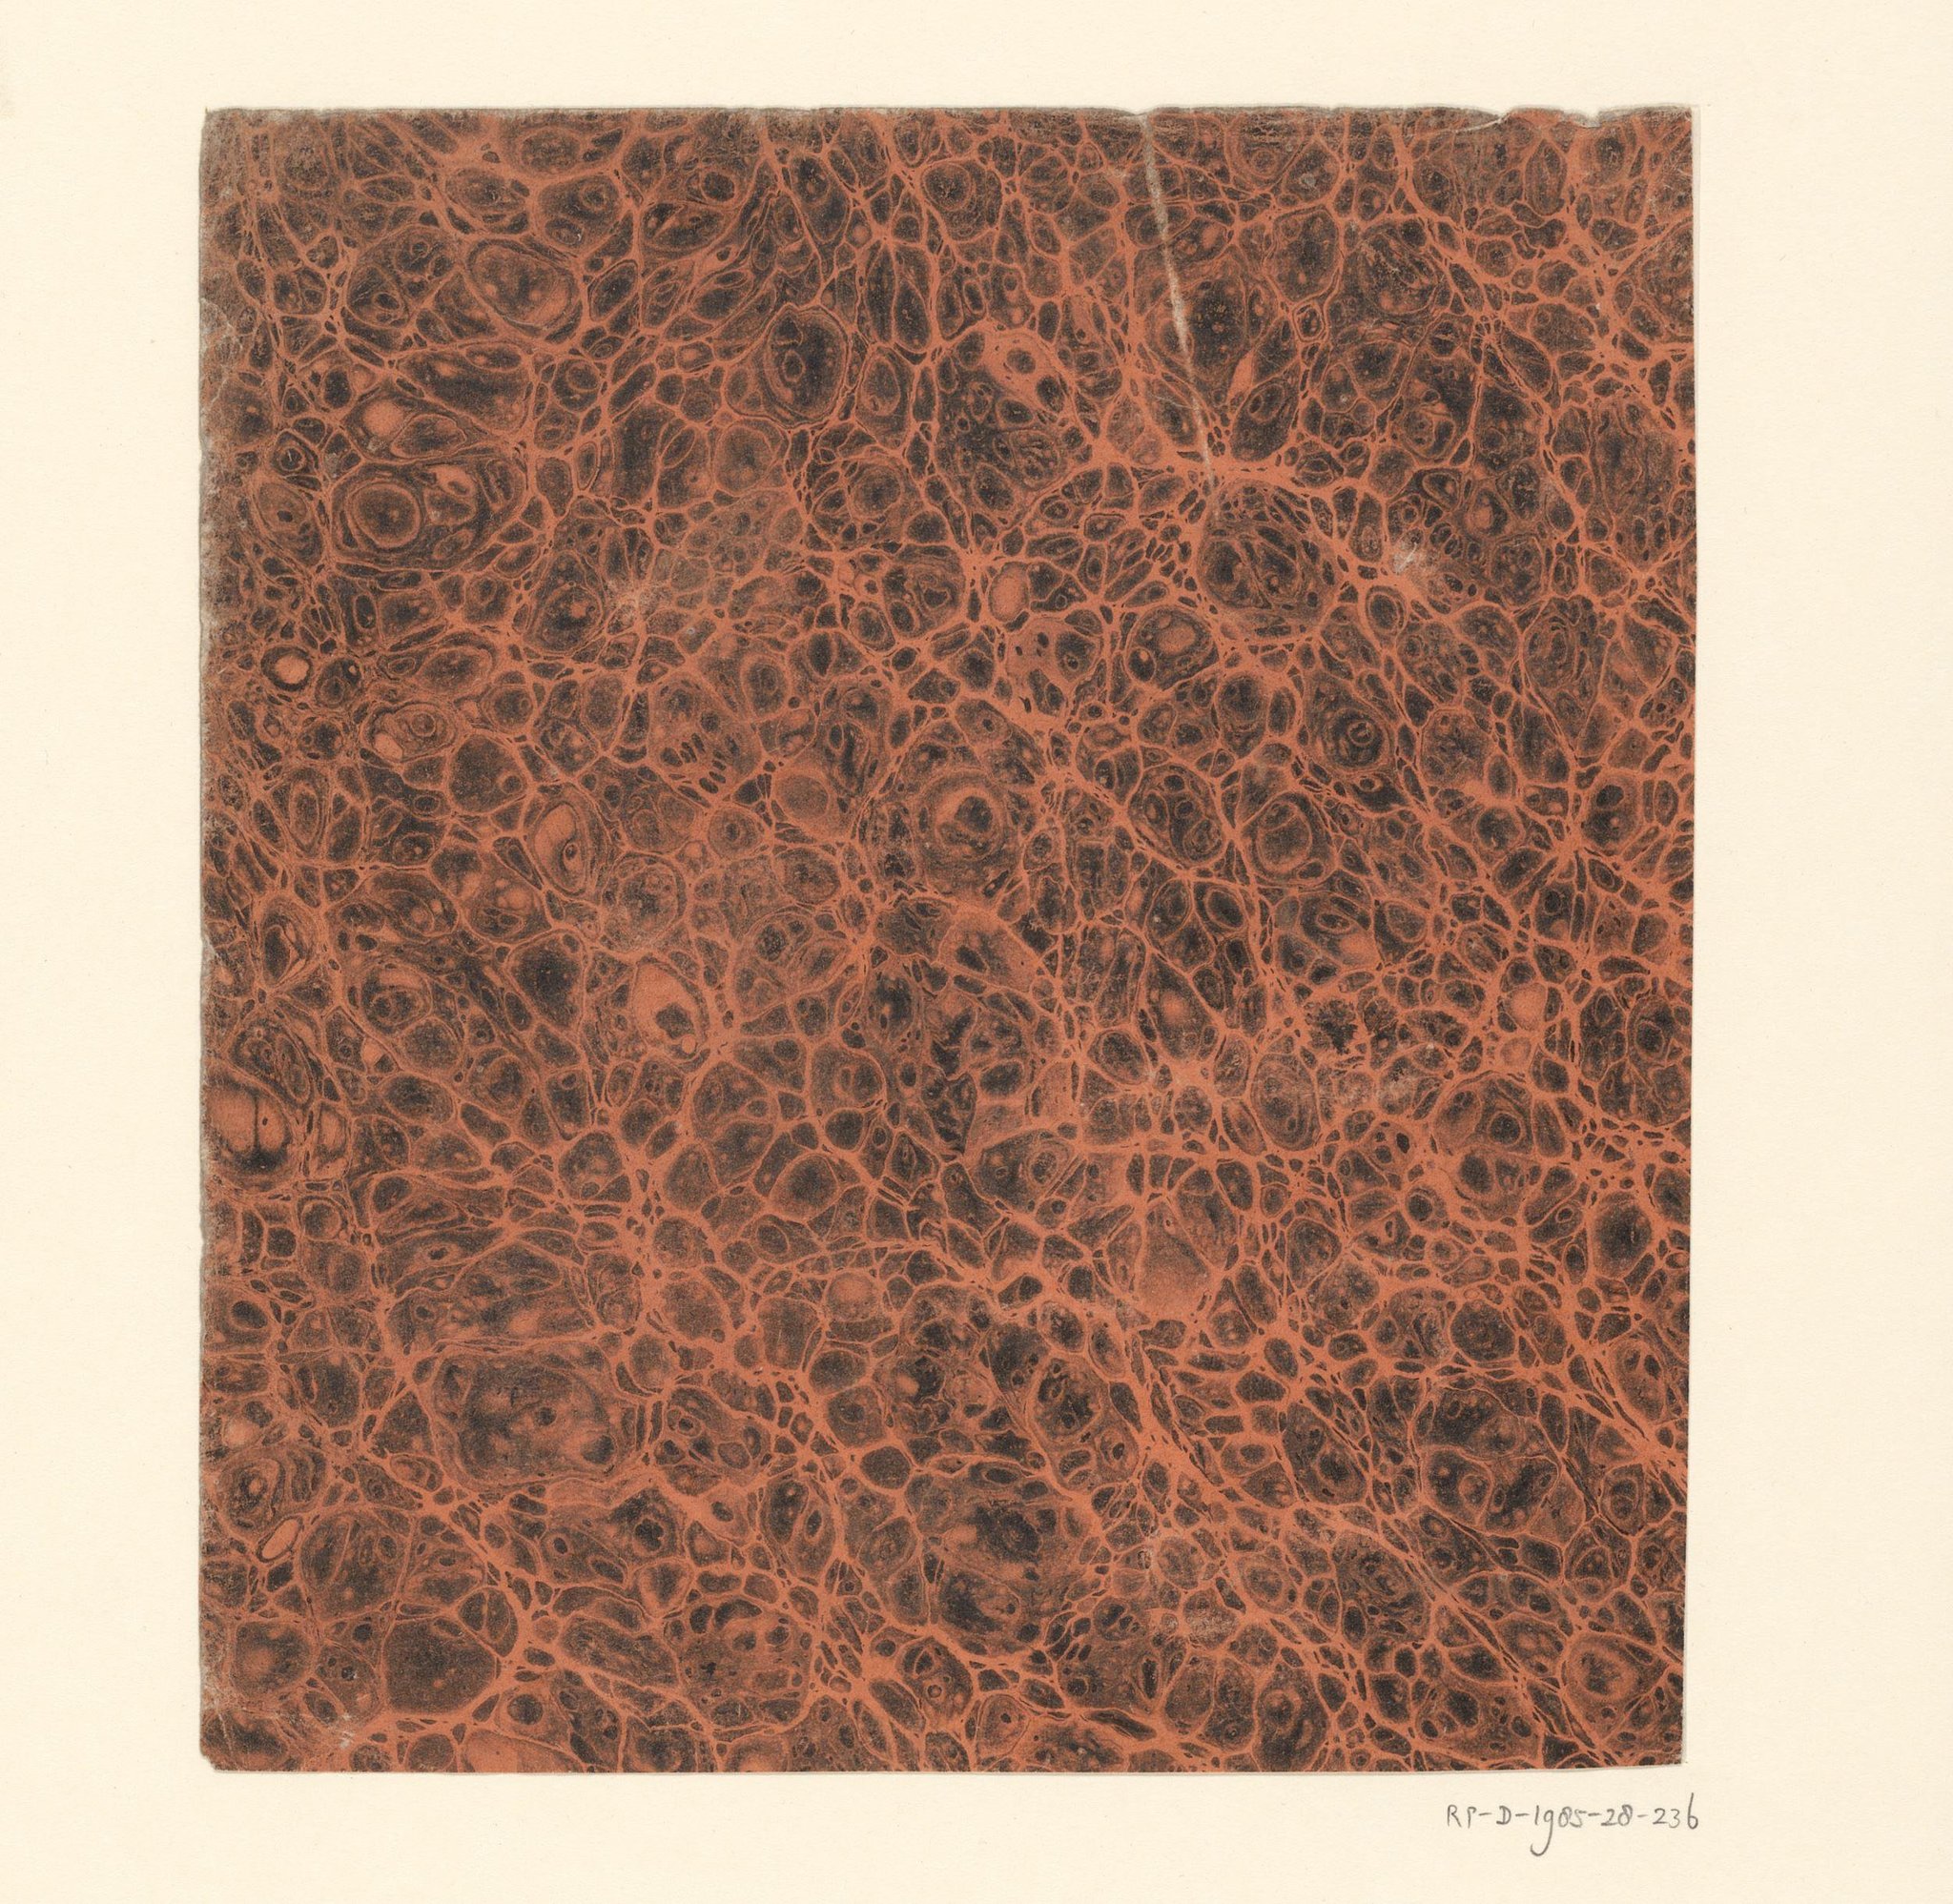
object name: marbled paper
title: Ringkiezelmarmer in oranje en grijs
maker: Anonymous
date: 1700-1950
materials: paint, paper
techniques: marbled paper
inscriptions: collector's mark: Lugt 2760, collector's mark: Lugt 2228